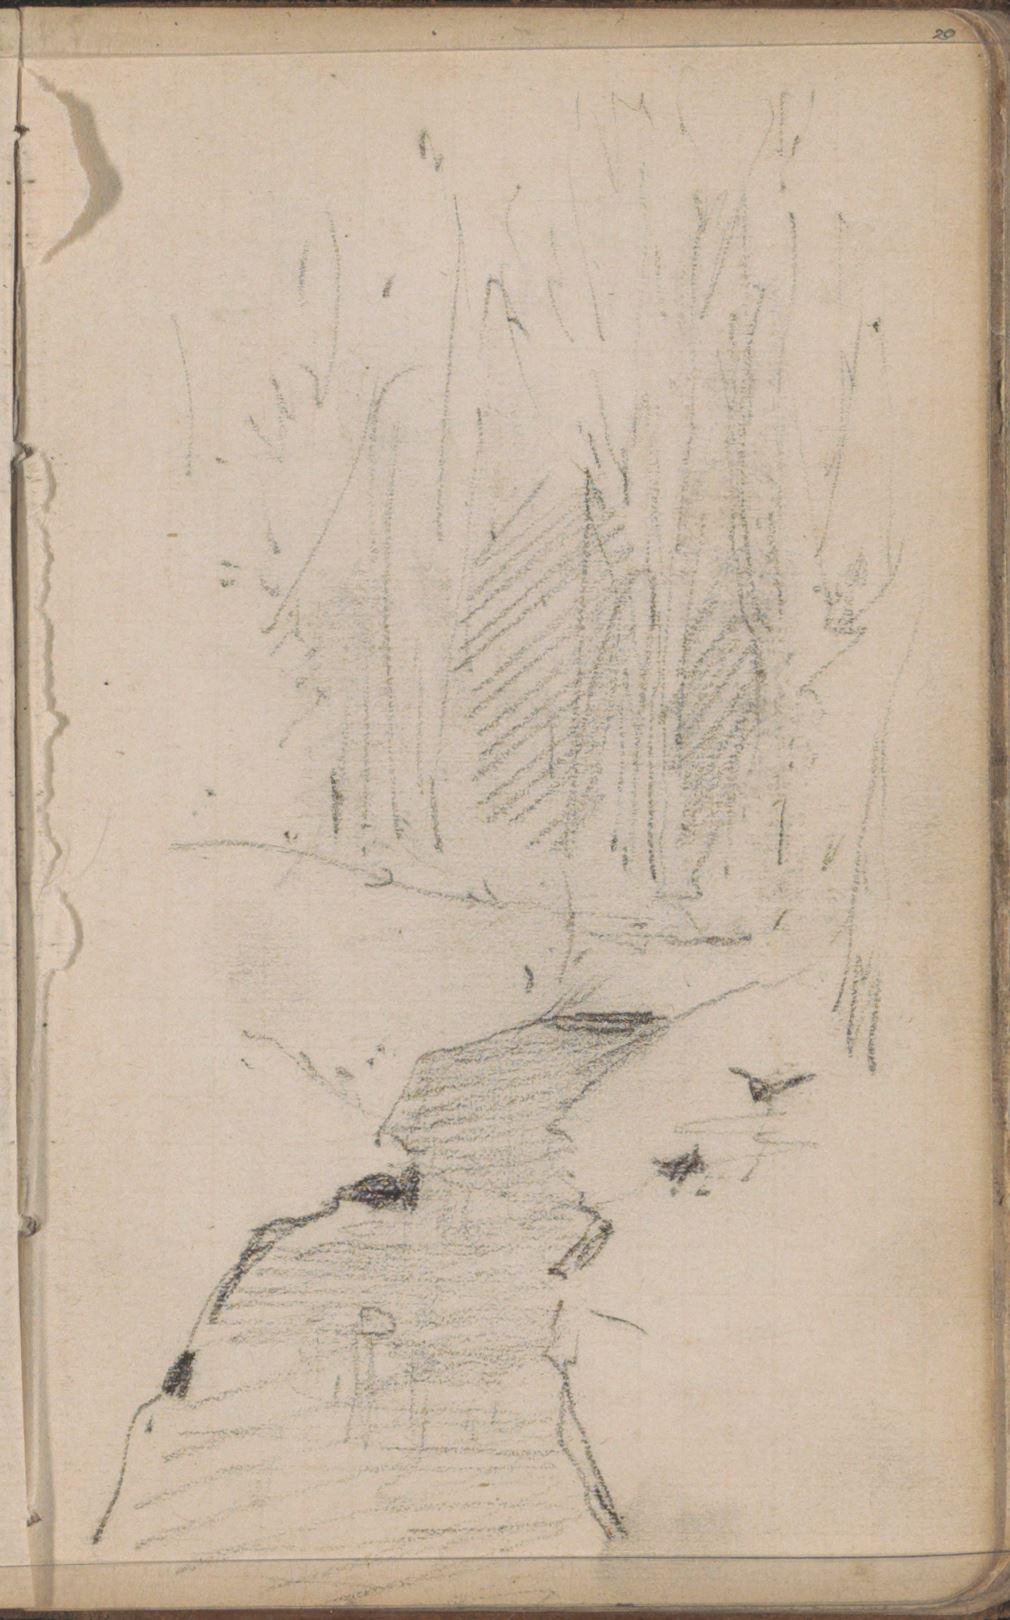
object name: sketchbook leaf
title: Beek bij een bos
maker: marius bauer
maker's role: draughtsman, print maker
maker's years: 1867-1932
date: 1879-1885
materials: chalk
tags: forest, wood, brook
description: Pagina 20 uit een schetsboek met 58 bladen.